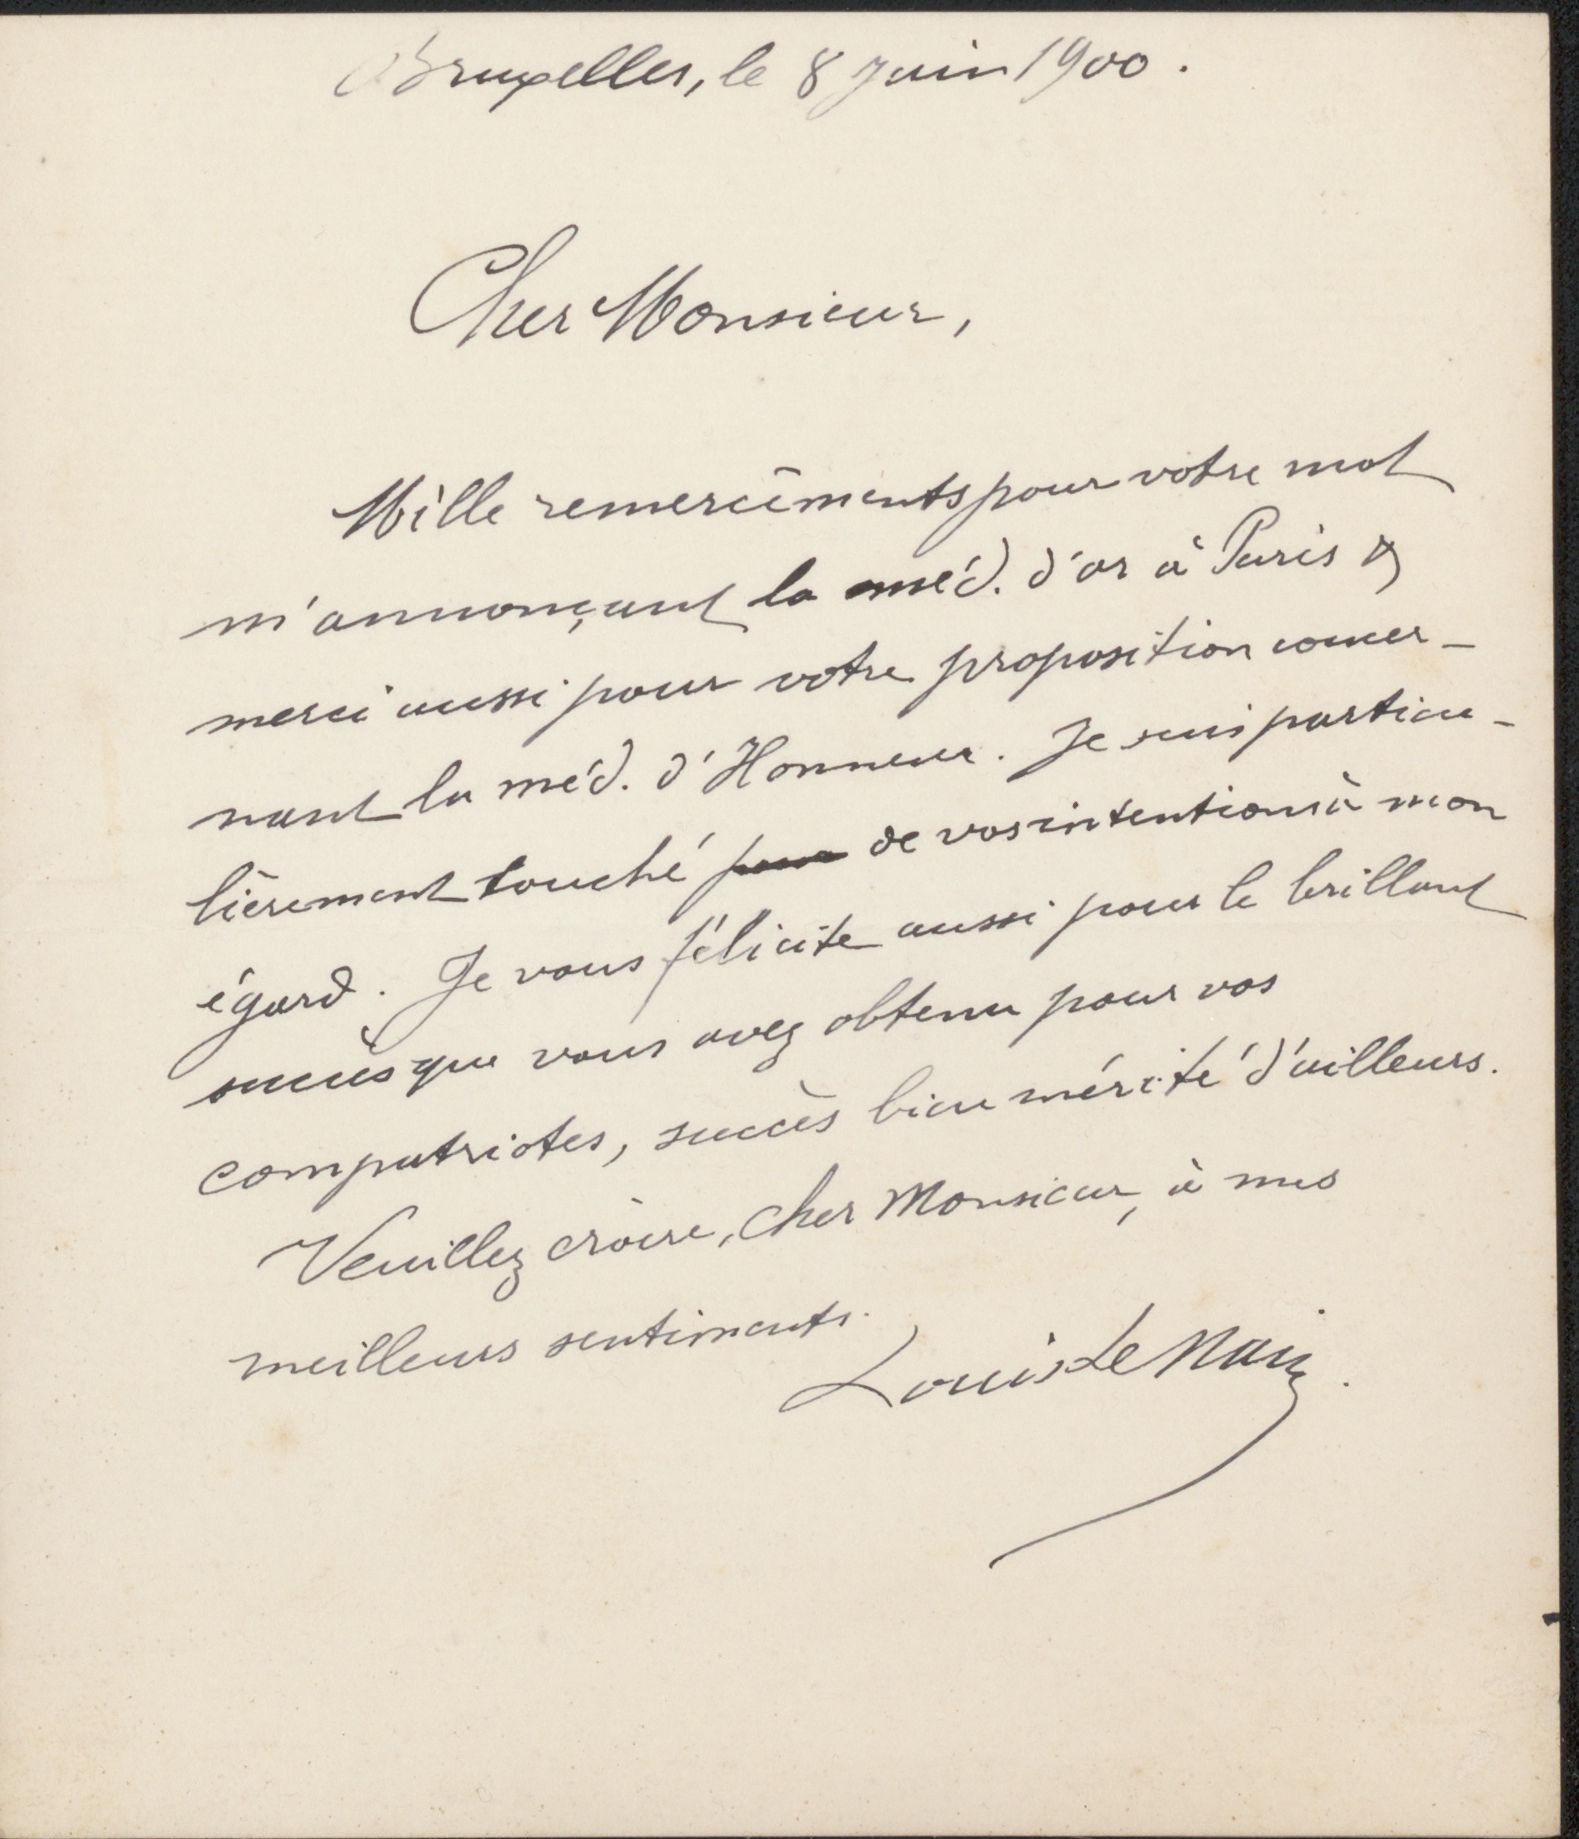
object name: letter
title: Brief aan Philip Zilcken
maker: louis le nain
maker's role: print maker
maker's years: 1851-1939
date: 1900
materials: ink, paper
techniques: pen, writing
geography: brussels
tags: the hague, painter, draughtsman, philip zilcken, distribution of awards ~ art contest, paris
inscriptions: collector's mark: ‘RPK’, watermark